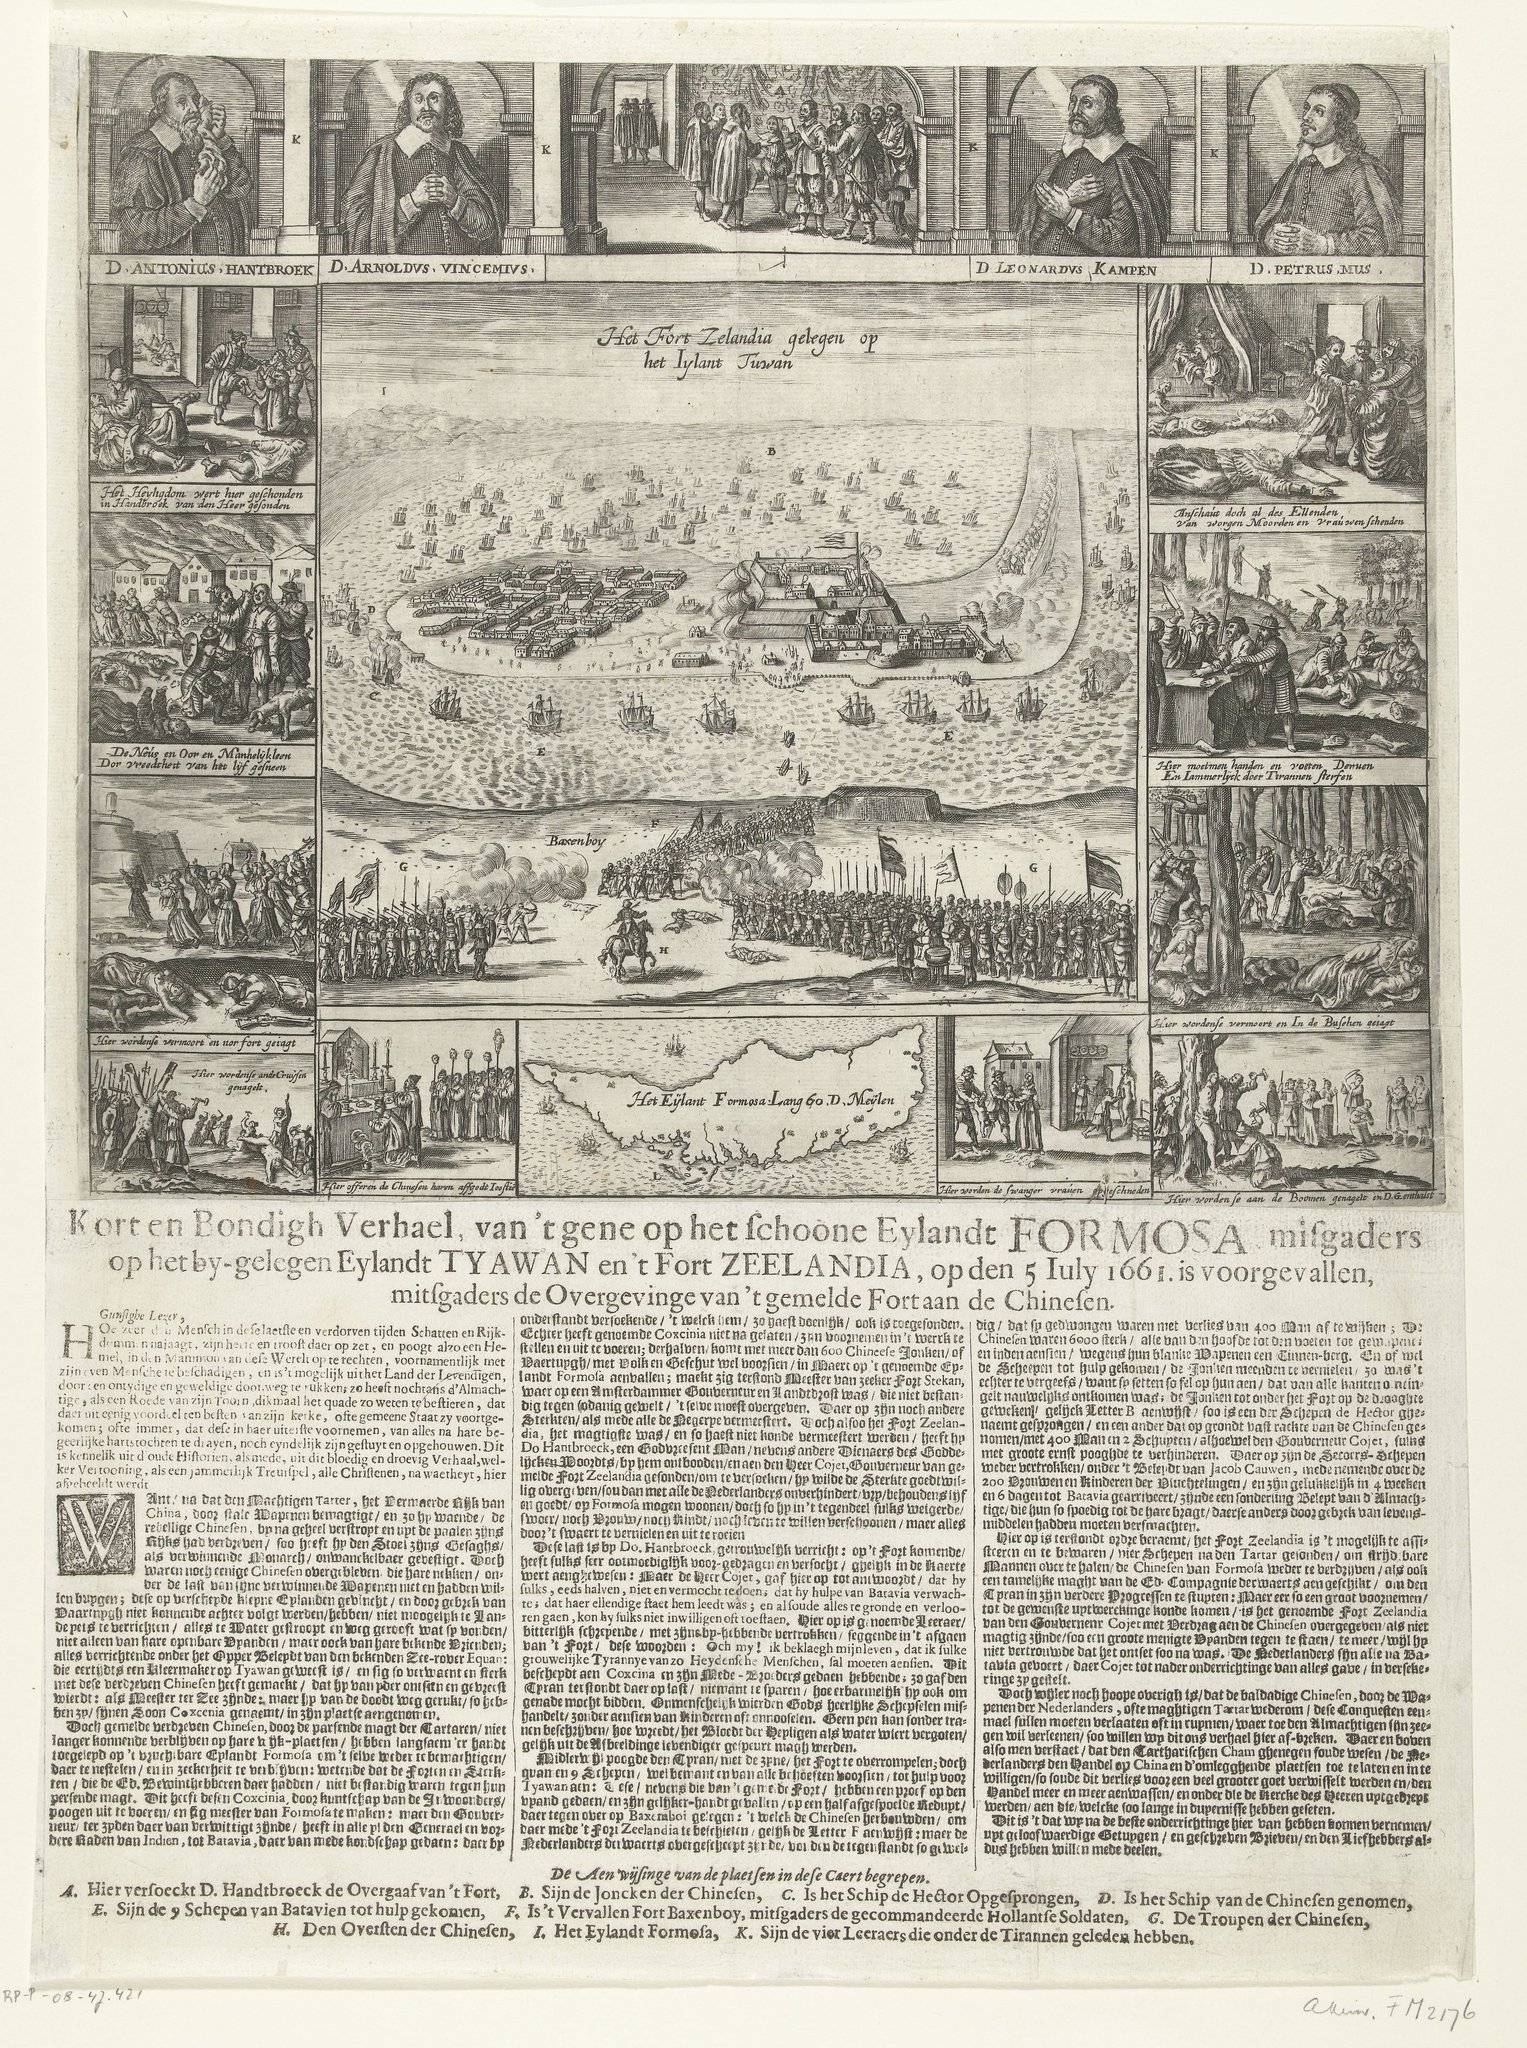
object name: print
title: Kort en Bondigh Verhael, van 't gene op het schoone Eylandt Formosa misgaders op het by-gelegen Eylandt Tyawan en 't Fort Zeelandia, op den 5 Juli 1661. is voorgevallen, mitsgaders de Overgevinge van 't gemelde Fort aan de Chinesen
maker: crispijn van de passe (ii)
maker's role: draughtsman, print maker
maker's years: 1594-1670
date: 1662-1663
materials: paper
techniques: engraving, letterpress printing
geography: amsterdam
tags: rotterdam, formosa, capture of city (after the siege), torture, violent death, being killed; being mishandled and maltreated; seeking death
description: Verovering van Fort Zeelandia op Formosa door de Chinezen en de marteling en moord op de gereformeerde predikanten. Vier gereformeerde predikanten en een ziekentrooster gevangengenomen, gemarteld en vermoord op Formosa door de Chinese zeerover Coxinga, 5 juli en oktober 1661. Bovenaan de portretten van de vier predikanten Antonius Hambroeck, Arnoldus Vincemius, Petrus Muts en Leonardus van Campen. In het midden brengt Hambroeck met verzoek om overgave van het fort over. Centraal een gezicht op de gevechten rond het fort Zeelandia. Hieromheen tien kleine voorstellingen van de wreedheden. Onder het blad is geplakt een tekst gedrukt in 3 kolommen met de legenda A-K.